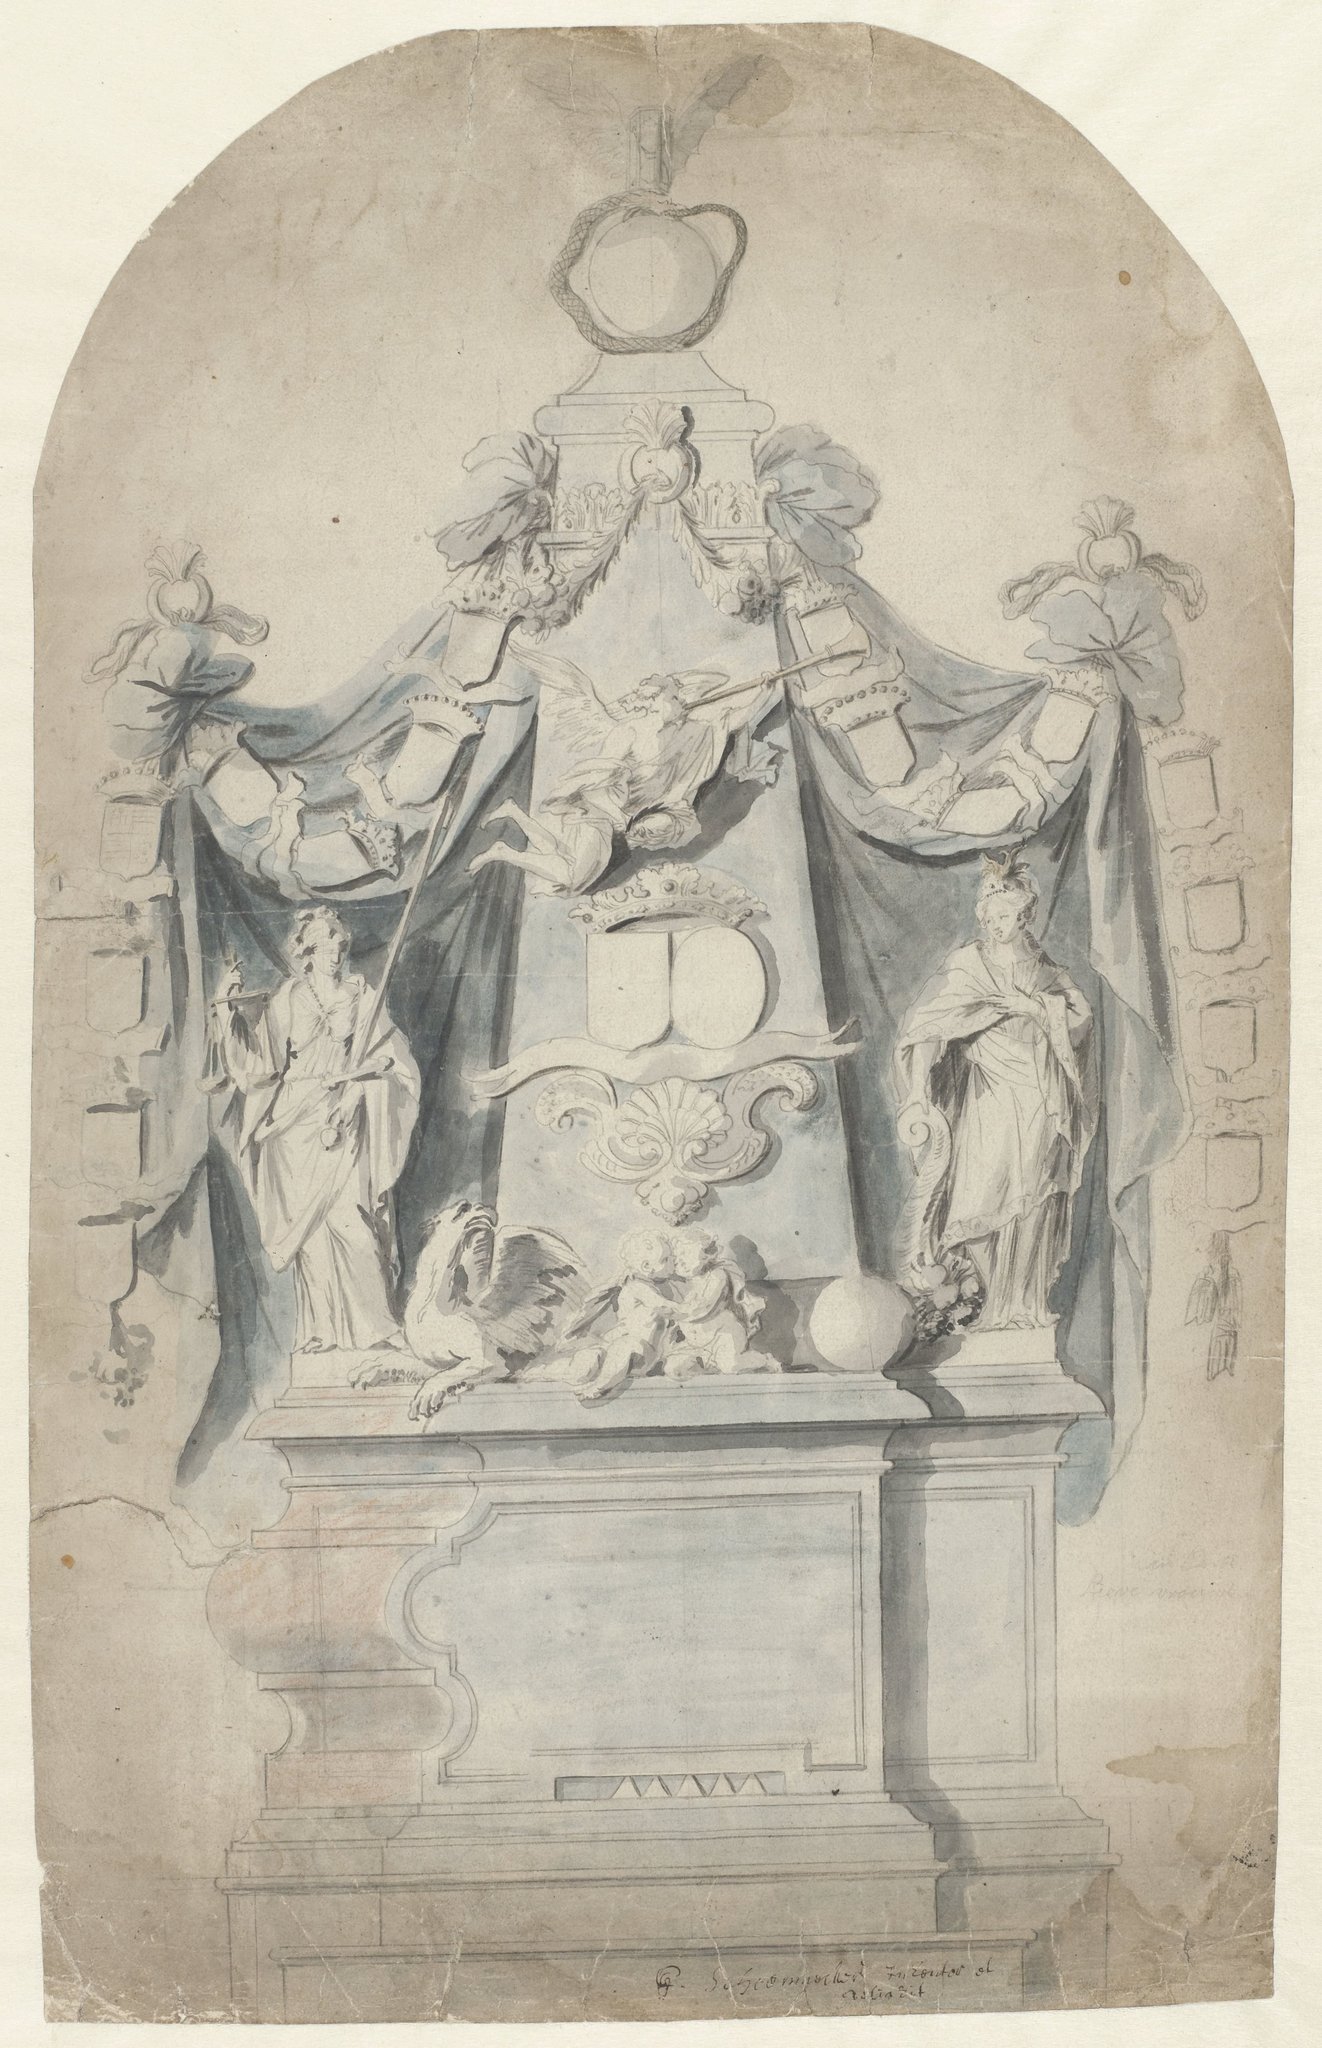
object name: design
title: Ontwerp voor een grafmonument met Justitia, Fama en Abundantia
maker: pieter scheemaeckers (i)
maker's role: draughtsman, sculptor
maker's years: 1652-1714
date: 1650-1714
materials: chalk, paper, pencil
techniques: brush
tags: justice, 'justitia'; 'giustitia divina' (ripa) ~ one of the four cardinal virtues, abundance; 'abondanza', 'abondanza maritima' (ripa), justice; 'forza alla giustitia sottoposta', 'giustitia', 'giustitia retta', 'giustitia rigorosa', 'impietà e violenza soggetta alla giustitia' (ripa), fame; 'fama', 'fama buona', 'fama chiara' (ripa), grave-building, monumental tomb